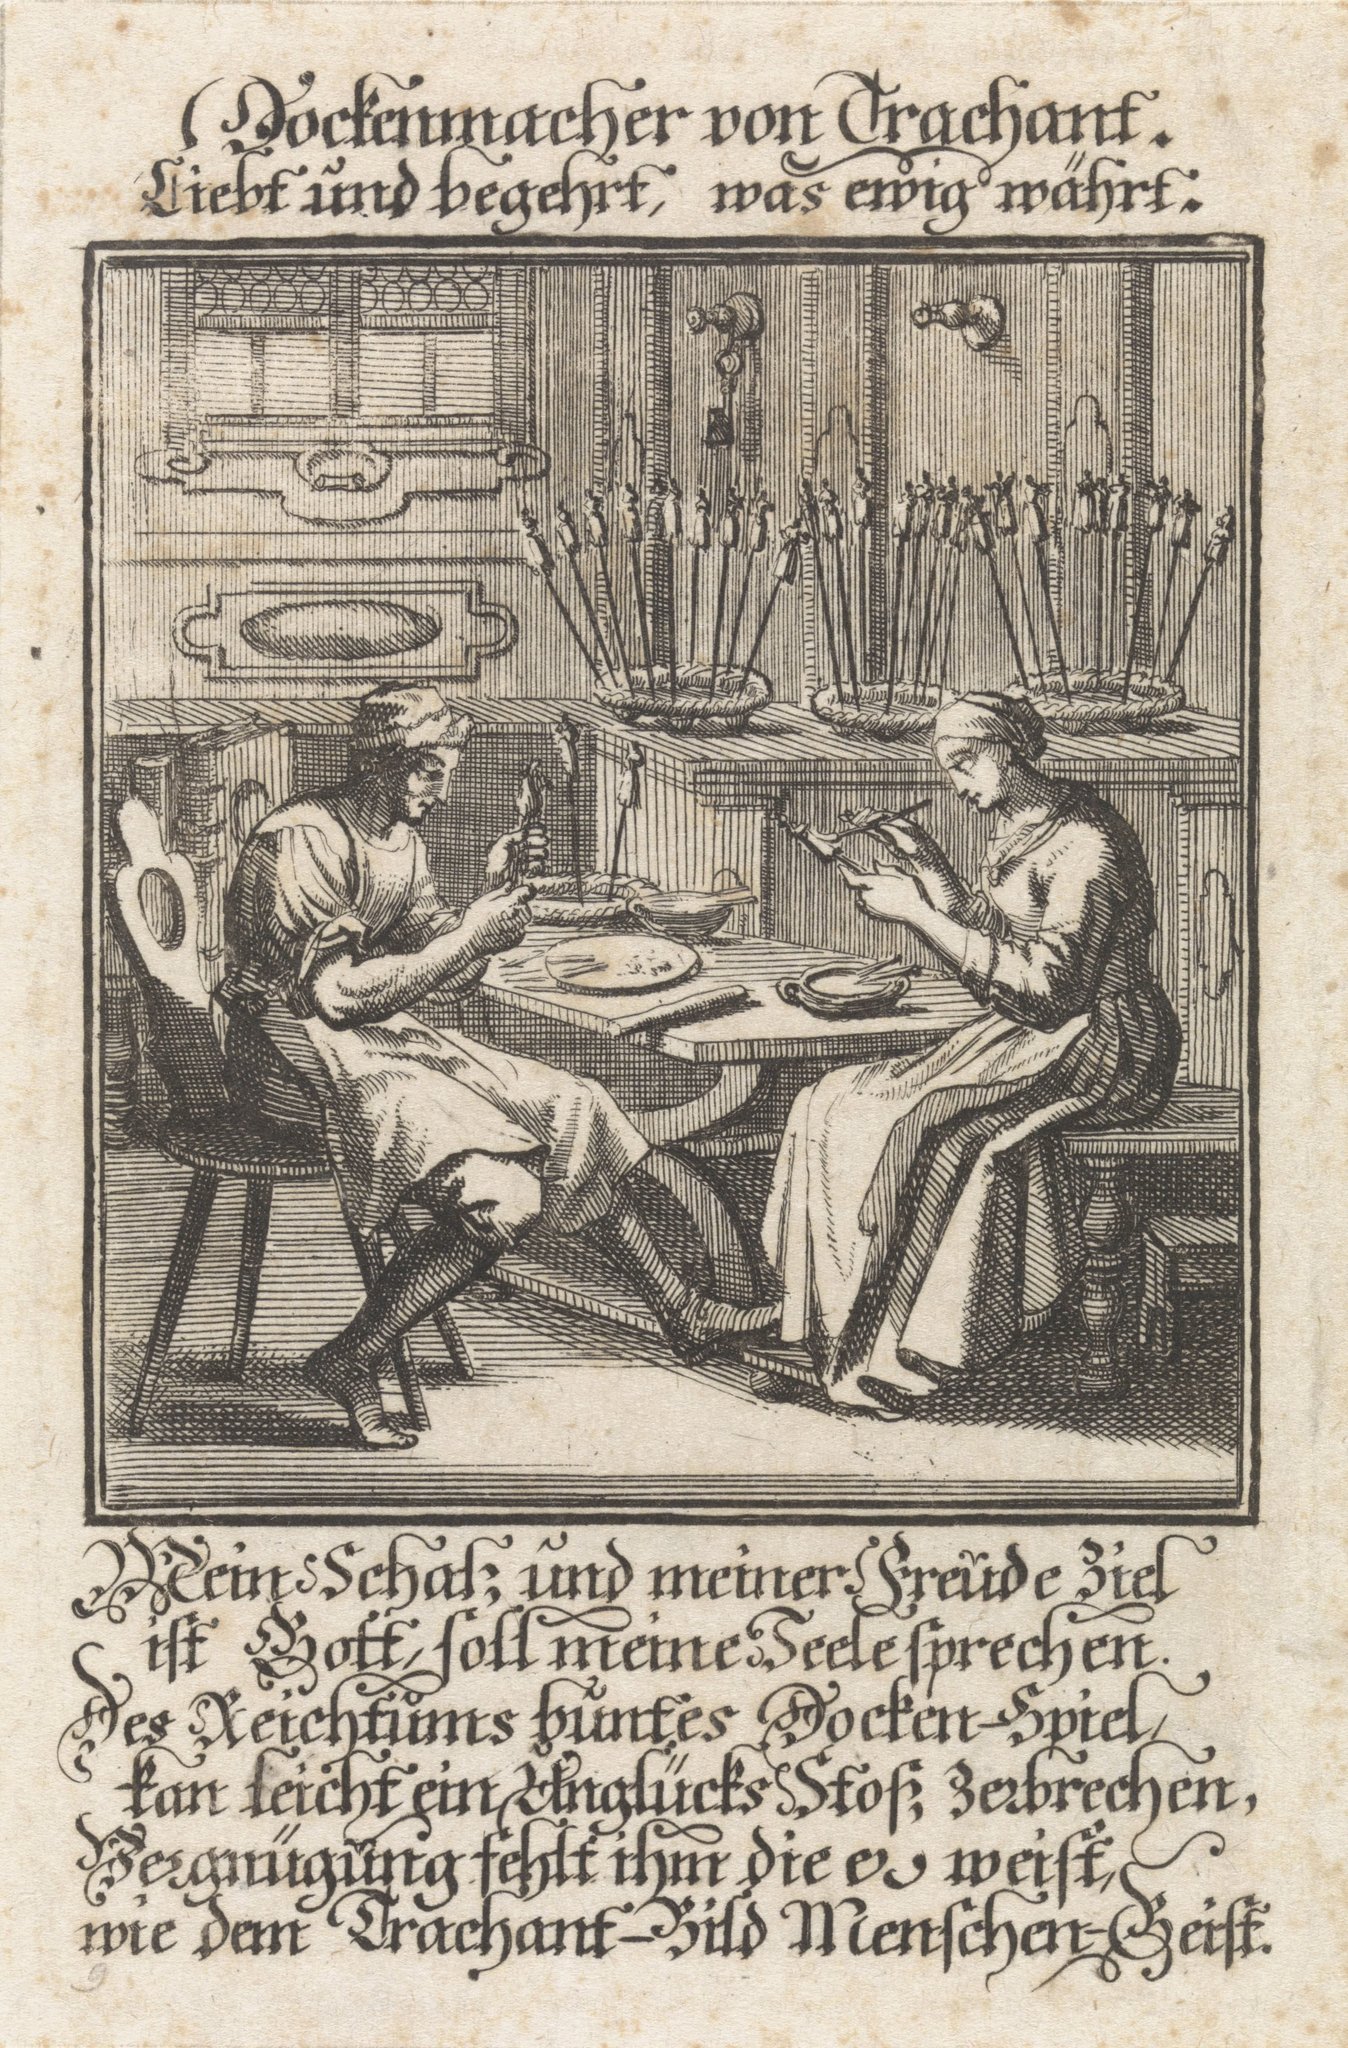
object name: book illustration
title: Dockenmacher von Trachant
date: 1698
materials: paper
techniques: etching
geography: amsterdam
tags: battle, fighting in general (+ land forces), handicrafts, craftsman at work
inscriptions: collector's mark: Lugt 2228, number: ‘9’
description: Illustratie uit: Weigel, Christoff. Abbildung Der Gemein-Nützlichen Haupt-Stände Von denen Regenten Und ihren So in Friedens- als Kriegs-Zeiten zugeordneten Bedienten an, biß auf alle Künstler Und Handwercker. Regenspurg 1698, p. 217.